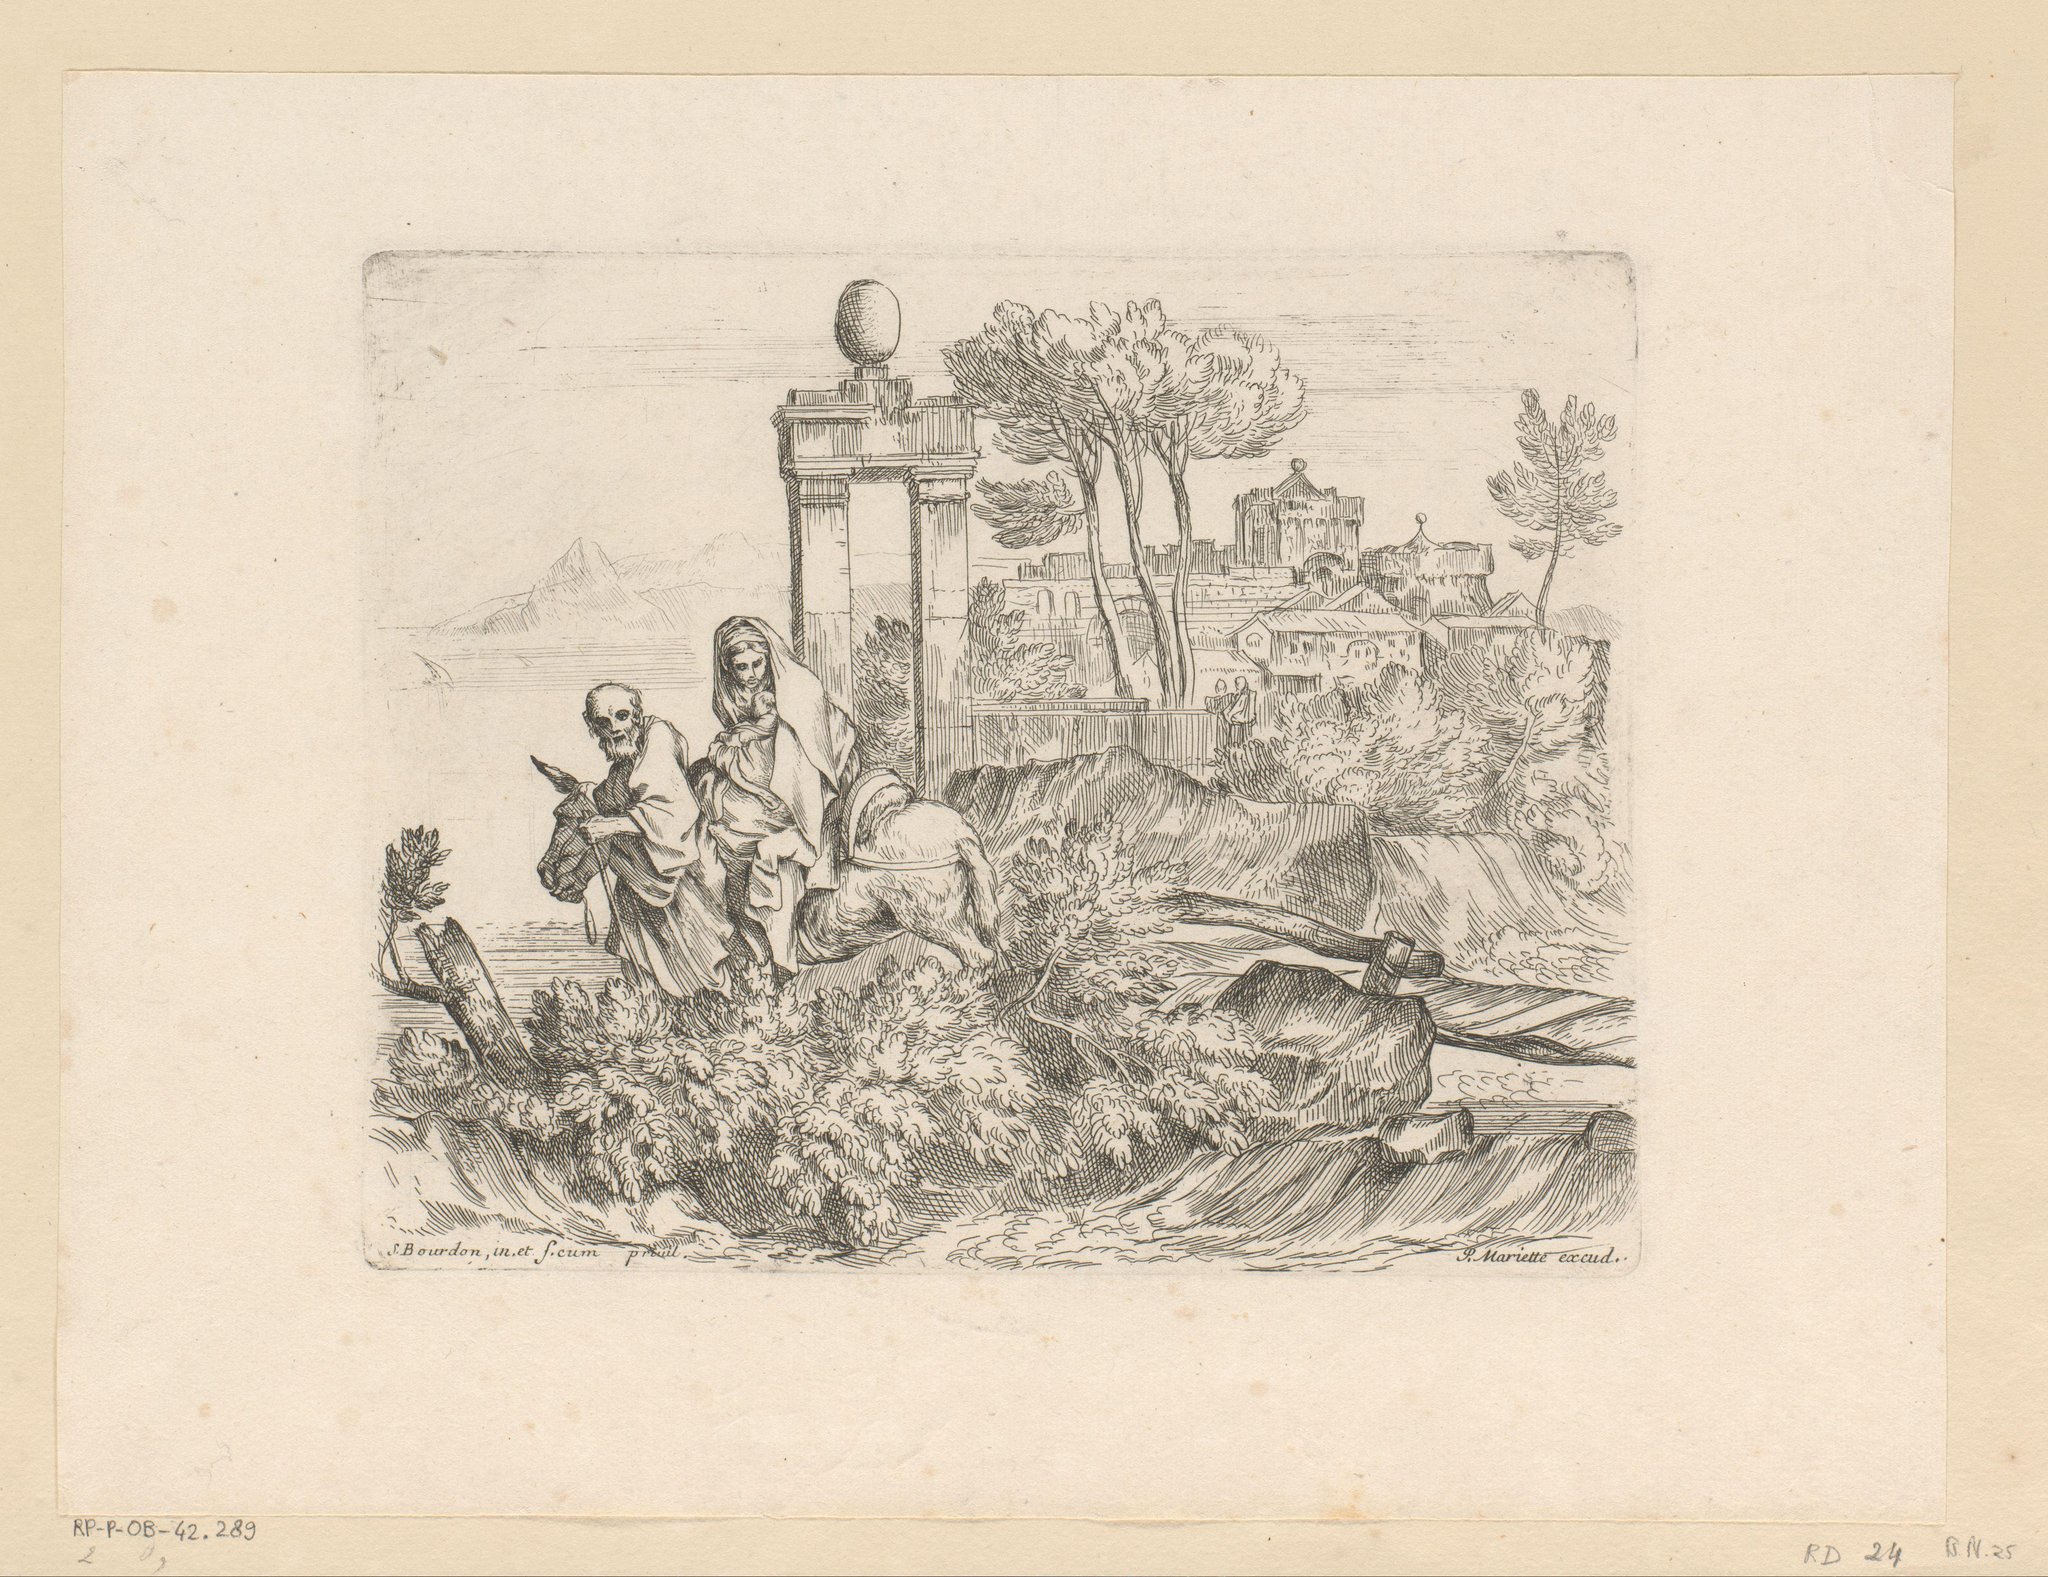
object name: print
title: Vlucht naar Egypte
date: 1626-1657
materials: paper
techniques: etching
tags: the flight into egypt: mary, joseph, the child (and sometimes others) on their way; mary usually riding on an ass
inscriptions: collector's mark: Lugt 240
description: Maakt deel uit van een serie van zes prenten met taferelen uit de vlucht naar Egypte.